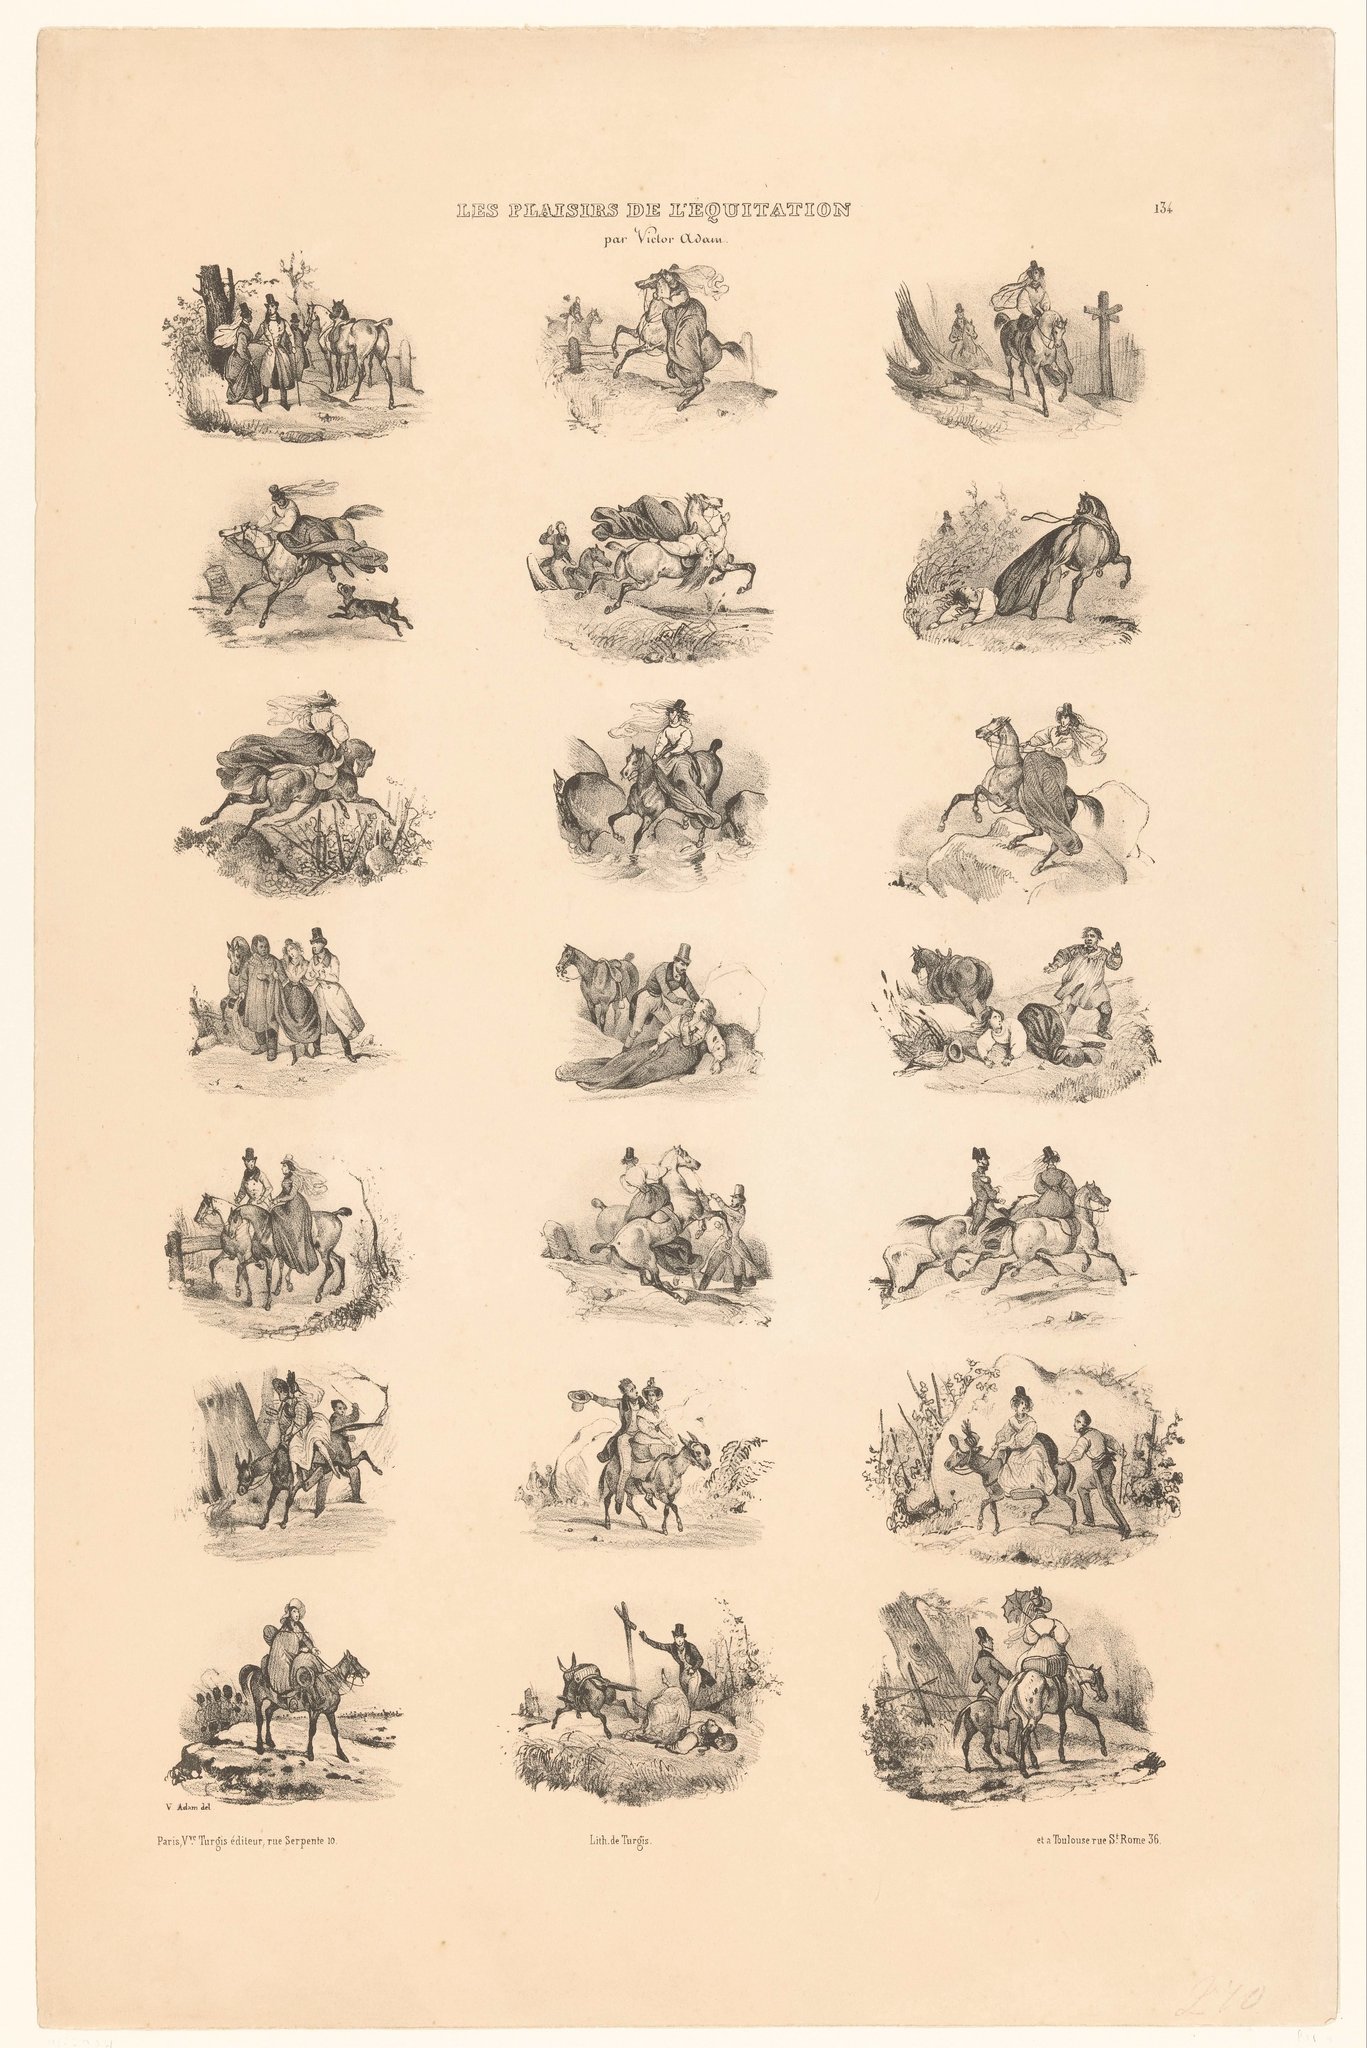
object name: print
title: 21 voorstellingen van paardrijdsters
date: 1847-1856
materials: paper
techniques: lithograph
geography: paris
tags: riding a horse, ass, or mule; rider, horseman, horse, accident with horse (or kindred animal)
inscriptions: annotation: ‘270’, collector's mark: Lugt 2228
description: Deze prent is uitgegeven als onderdeel van een serie waarvan de titel onbekend is. Een eerdere staat van deze prent is uitgegeven als onderdeel van de serie 'Les plaisirs de l'équitation'.